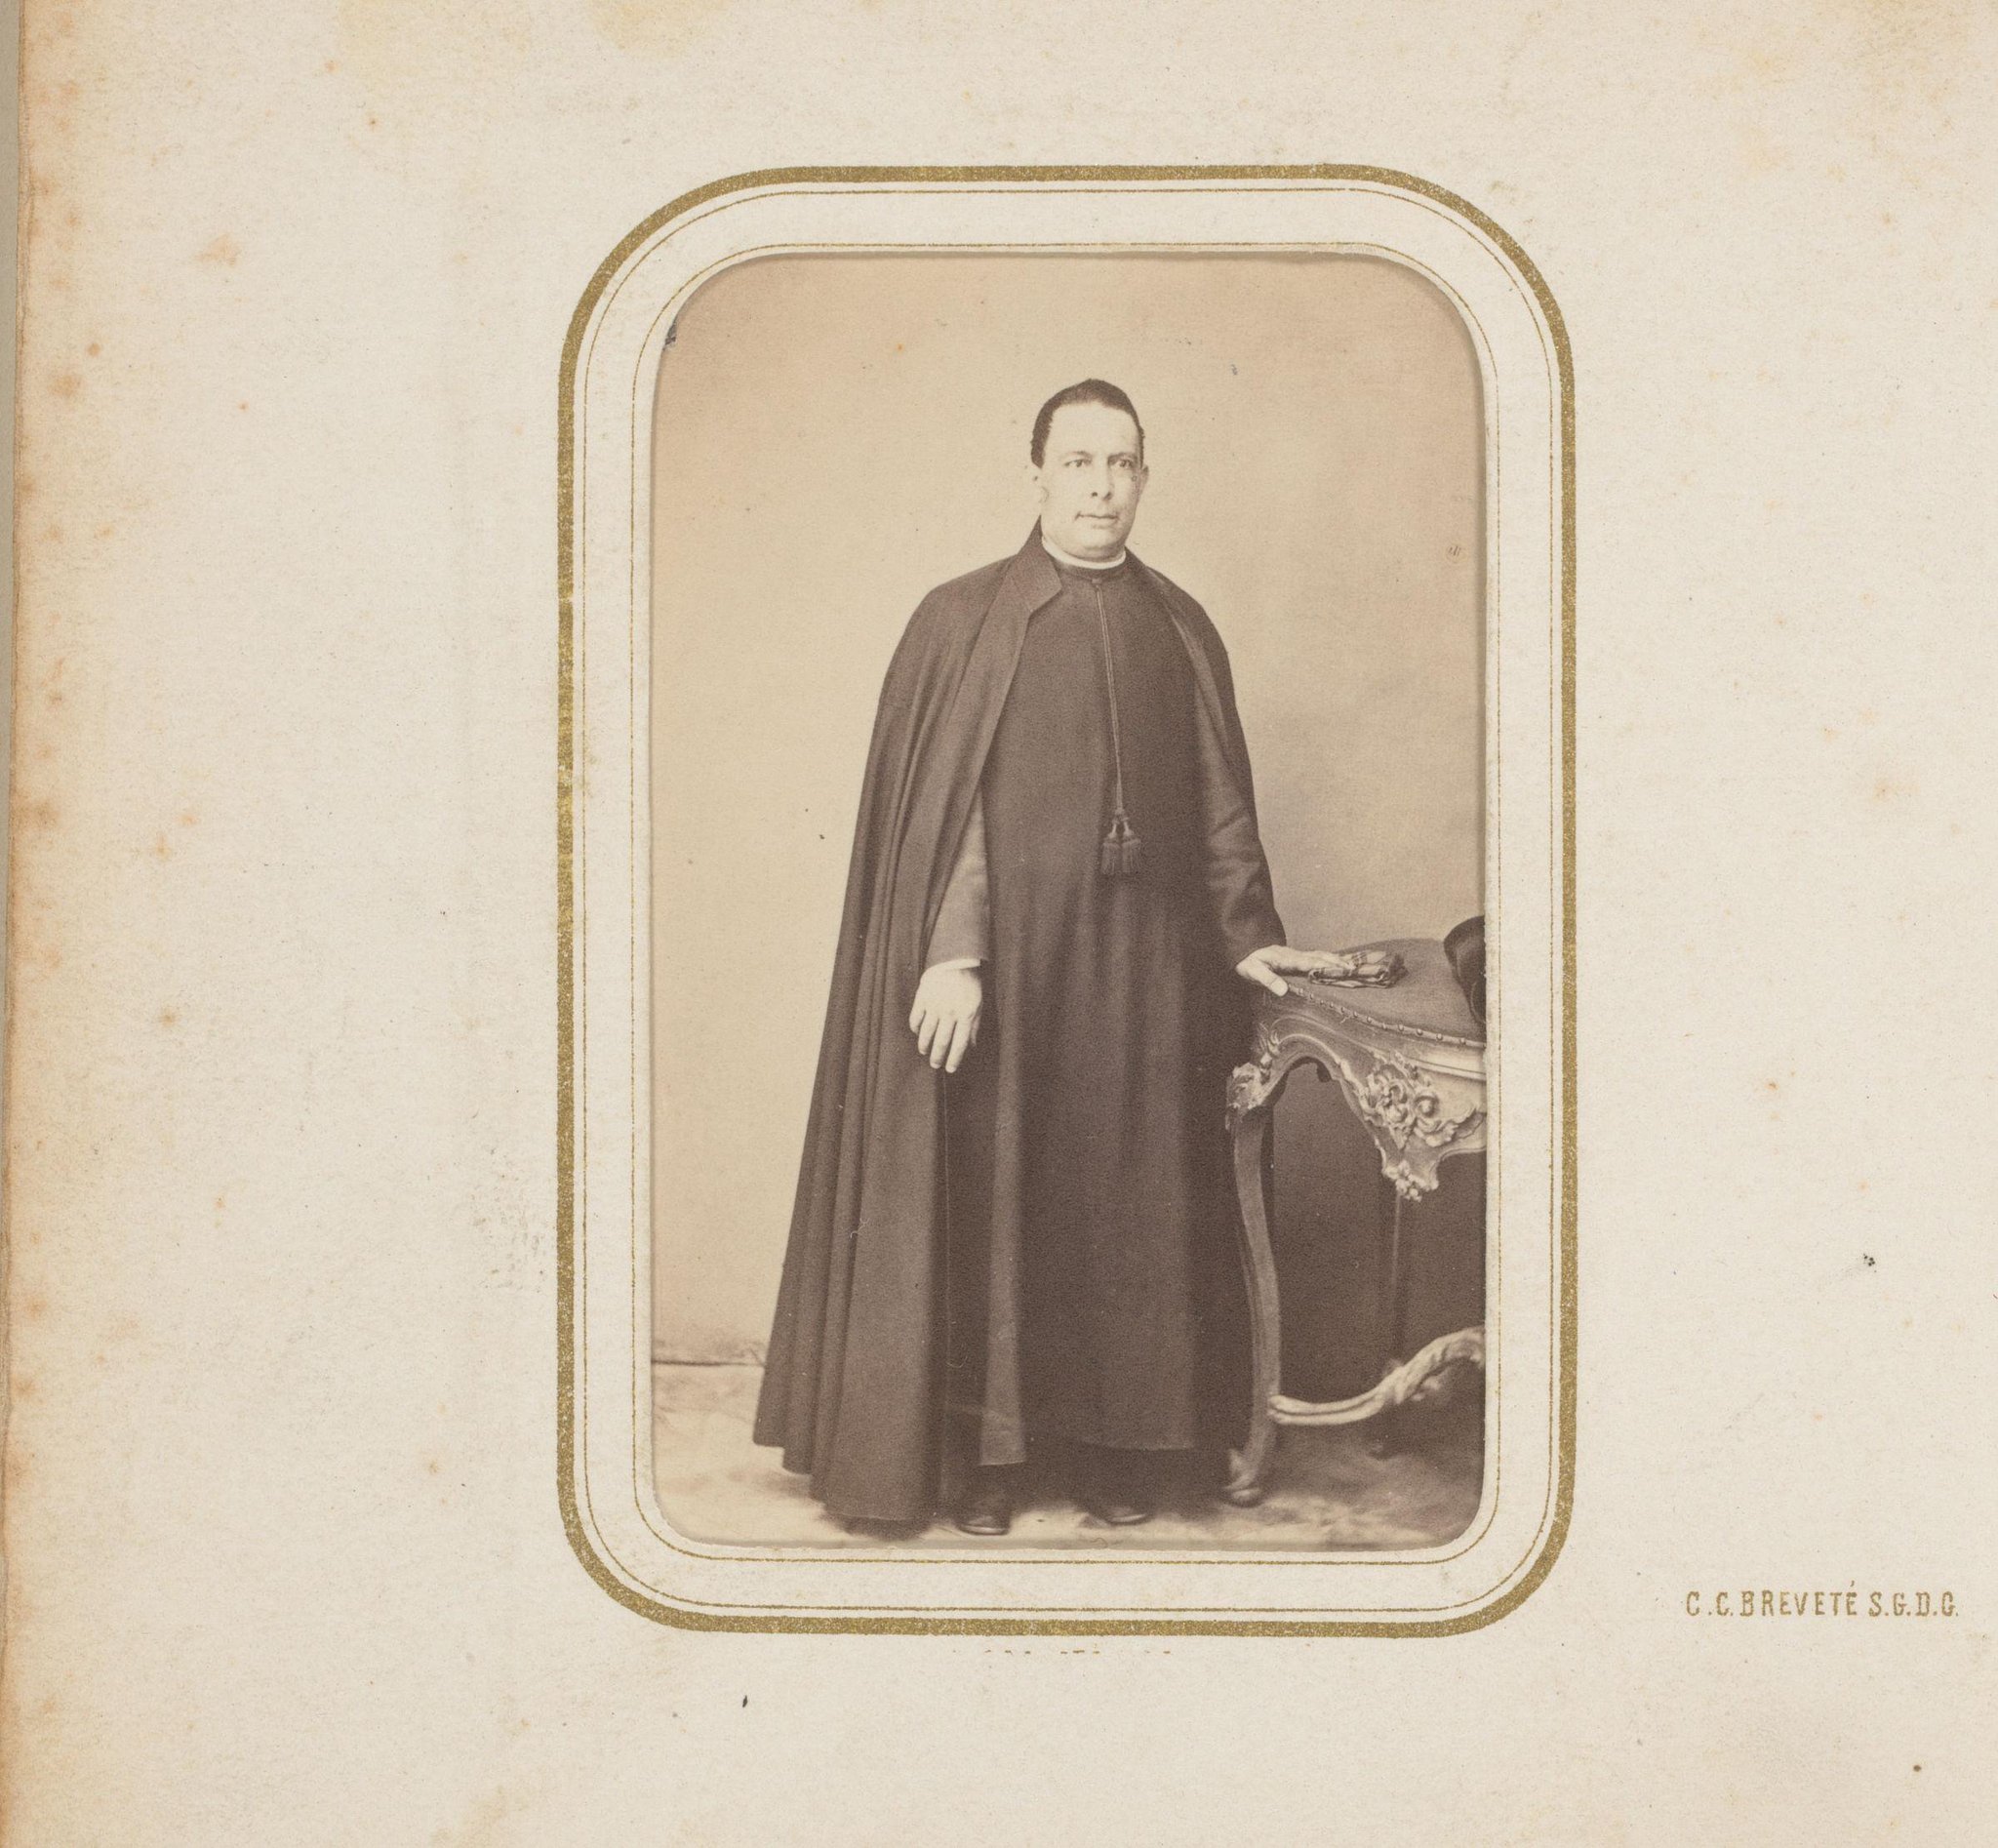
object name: photograph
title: Portret van een geestelijke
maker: francisco contreras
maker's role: fotograaf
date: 1860-1900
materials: cardboard, photographic support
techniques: albumen print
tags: adult man, historical persons, organization, functionaries and dignitaries in churches and in related institutions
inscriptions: inscription: ‘S. Matias/ F. Contreras/ Granada/ Fotografo’